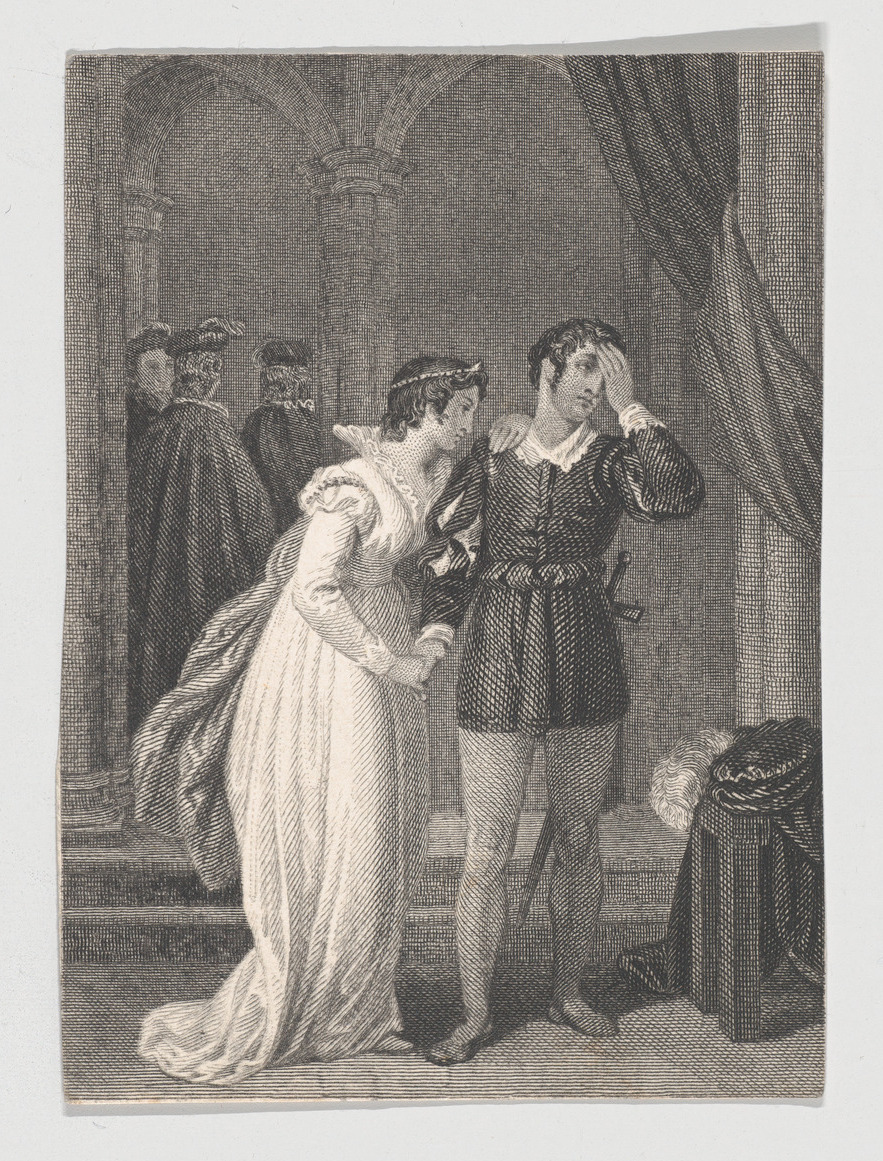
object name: print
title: Queen Margaret and Suffolk (Shakespeare, Henry VI, Part II, Act 3, Scene 2)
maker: charles heath, the elder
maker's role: engraver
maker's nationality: british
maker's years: 1785-1848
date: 1825-1840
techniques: engraving, etching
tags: queens,shakespeare,men